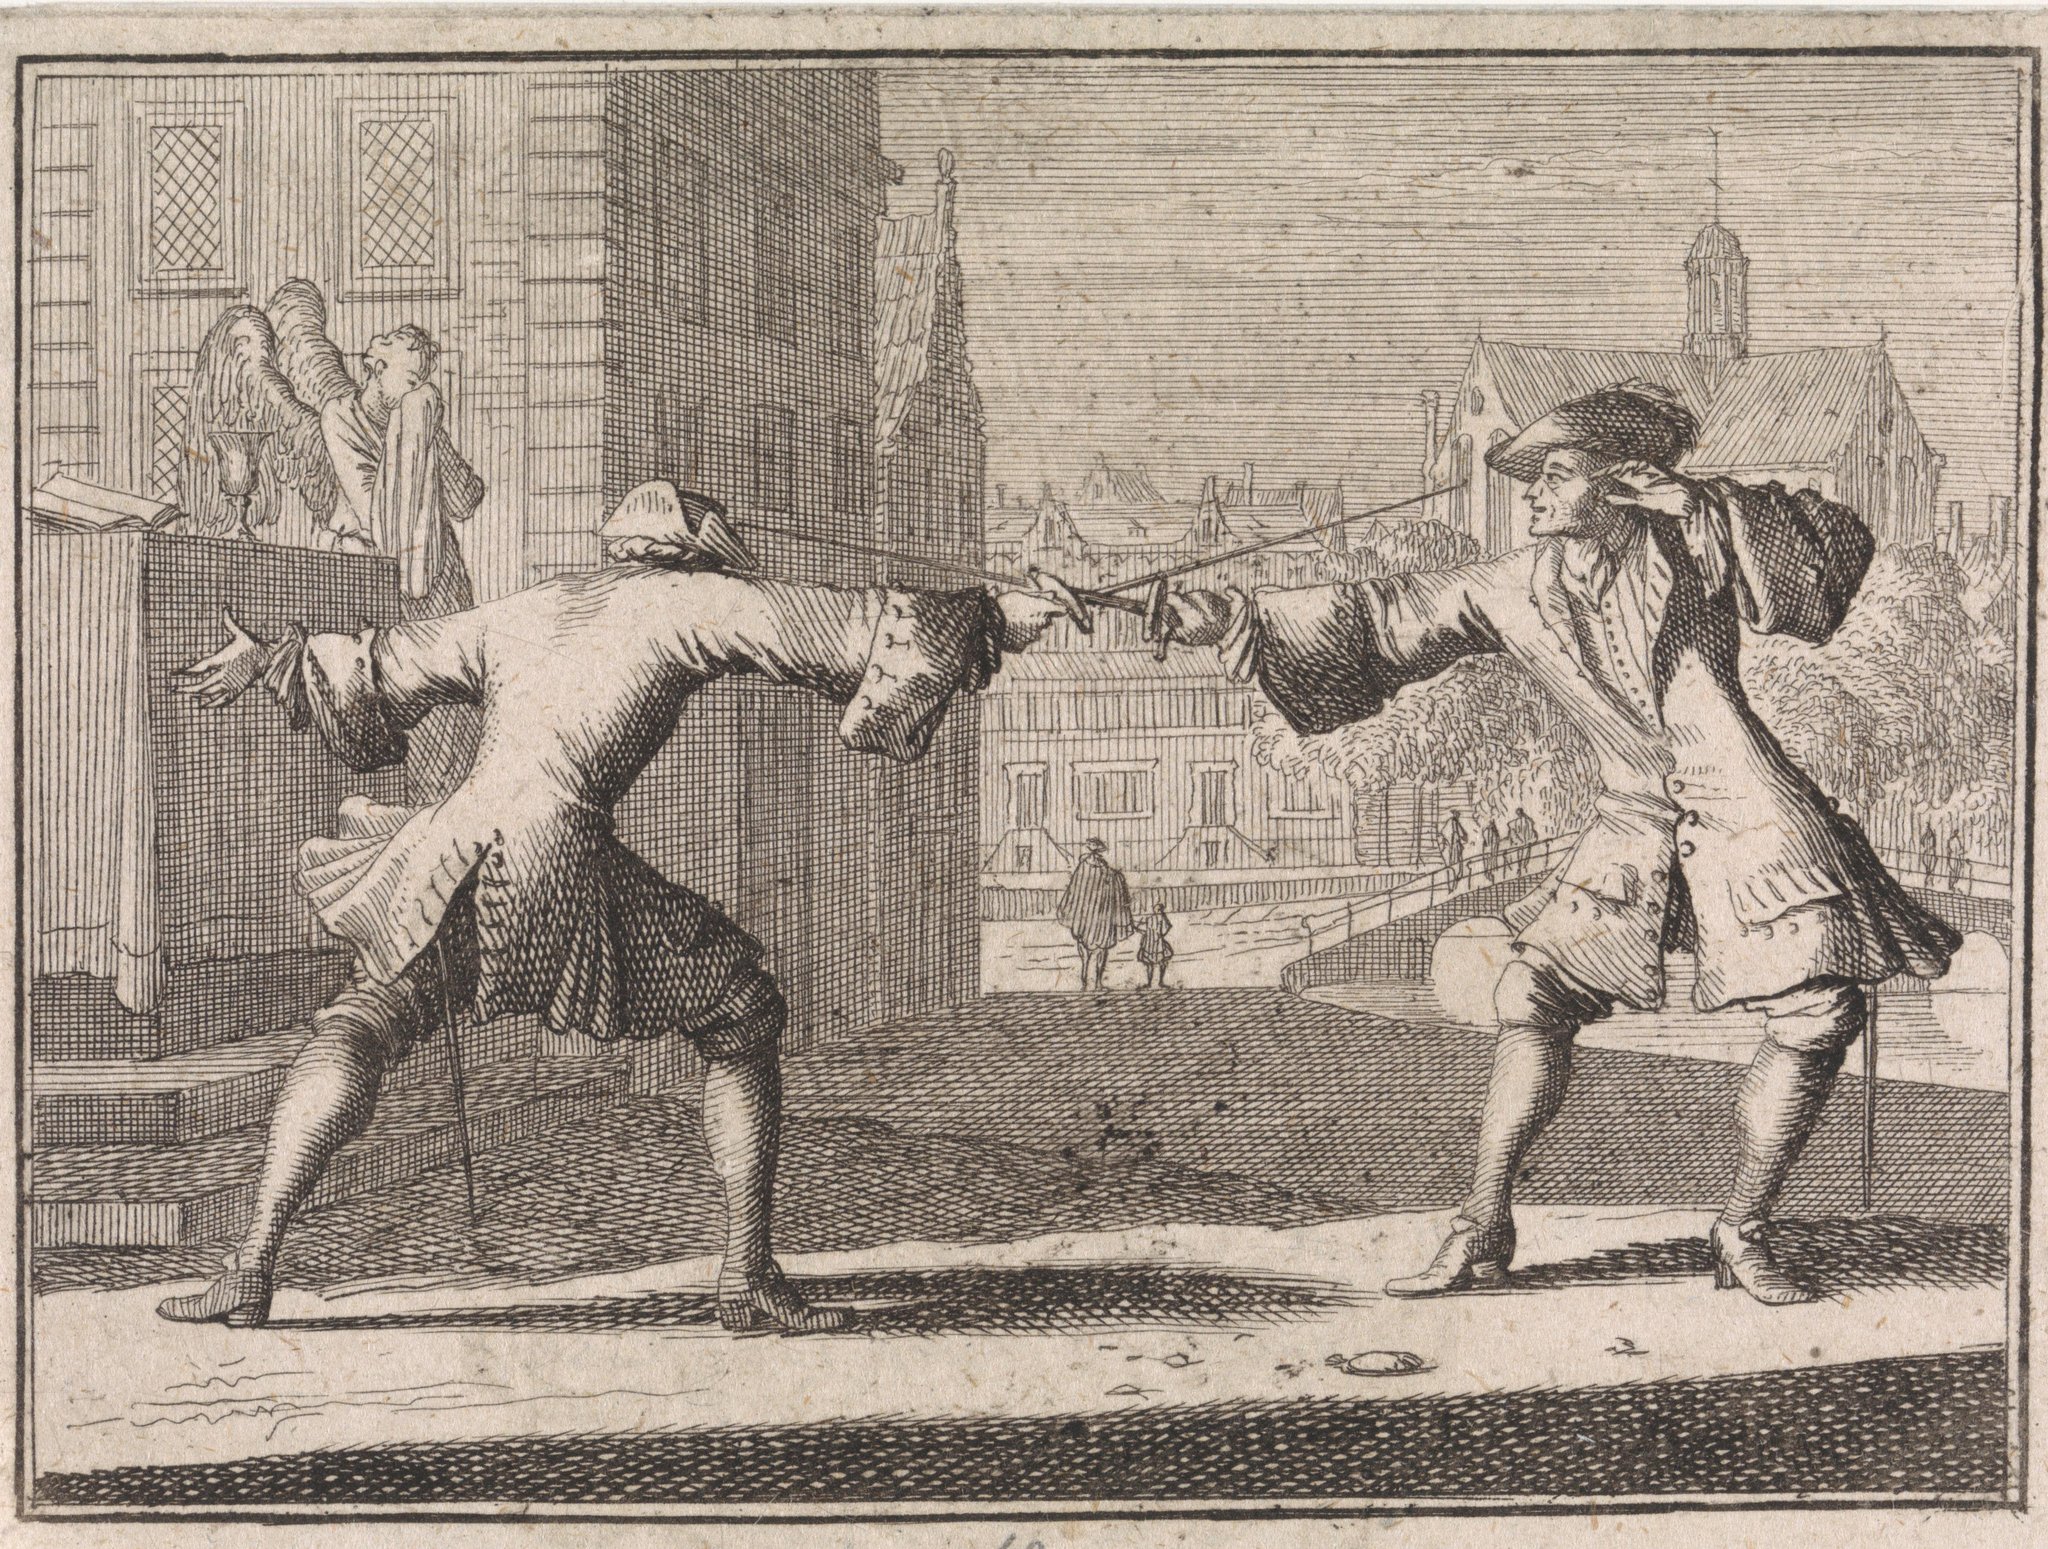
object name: book illustration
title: Der entkräffte Duellant, und treue secundant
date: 1710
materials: paper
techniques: etching, letterpress printing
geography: nuremberg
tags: duelling, angels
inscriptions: collector's mark: Lugt 2228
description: Illustratie uit: Abraham a Sancta Clara. Heilsames Gemisch Gemasch, das ist: Allerley seltsame und verwunderliche Geschichten (...). Neurenberg: Christoph Weigel, 1710, p. 396.